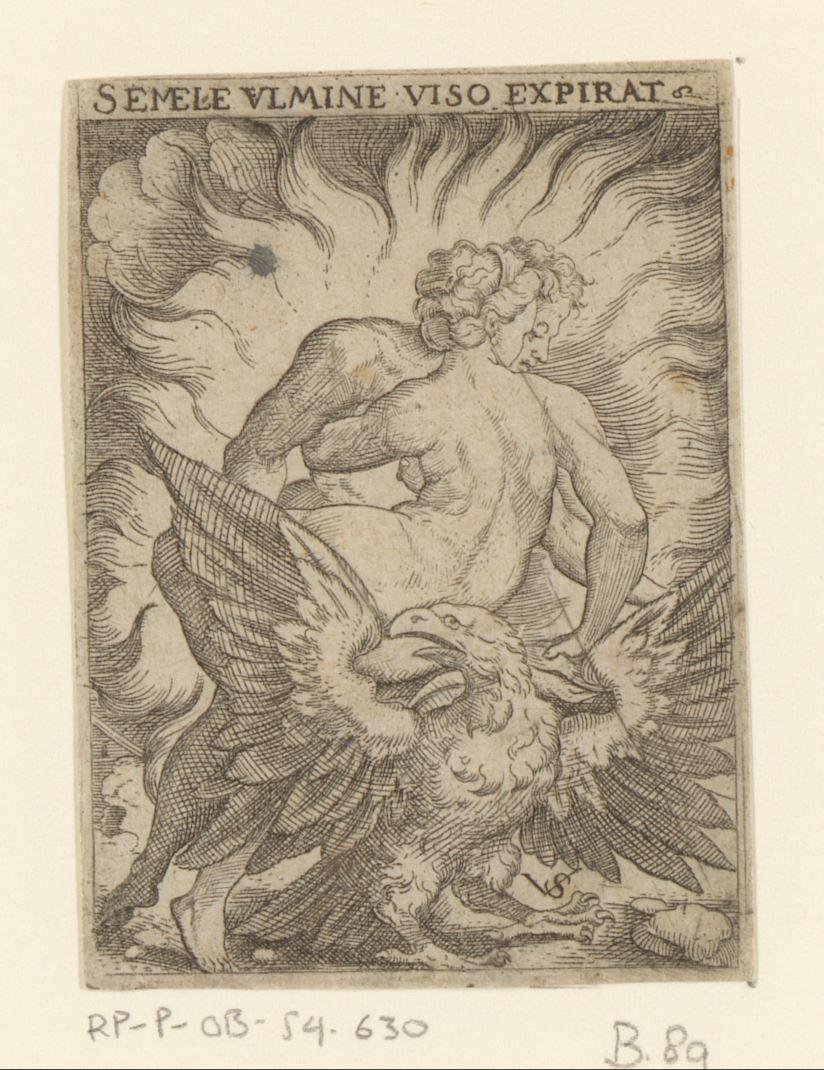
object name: print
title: Jupiter en Semele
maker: virgilius solis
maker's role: draughtsman, print maker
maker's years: 1514-1562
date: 1524-1562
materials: paper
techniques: engraving, etching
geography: nuremberg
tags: jupiter wooing semele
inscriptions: collector's mark: Lugt 2228, number: ‘93’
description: Prent maakt deel uit van een serie bestaande uit zeven prenten met de verschillende liefdes van Jupiter.